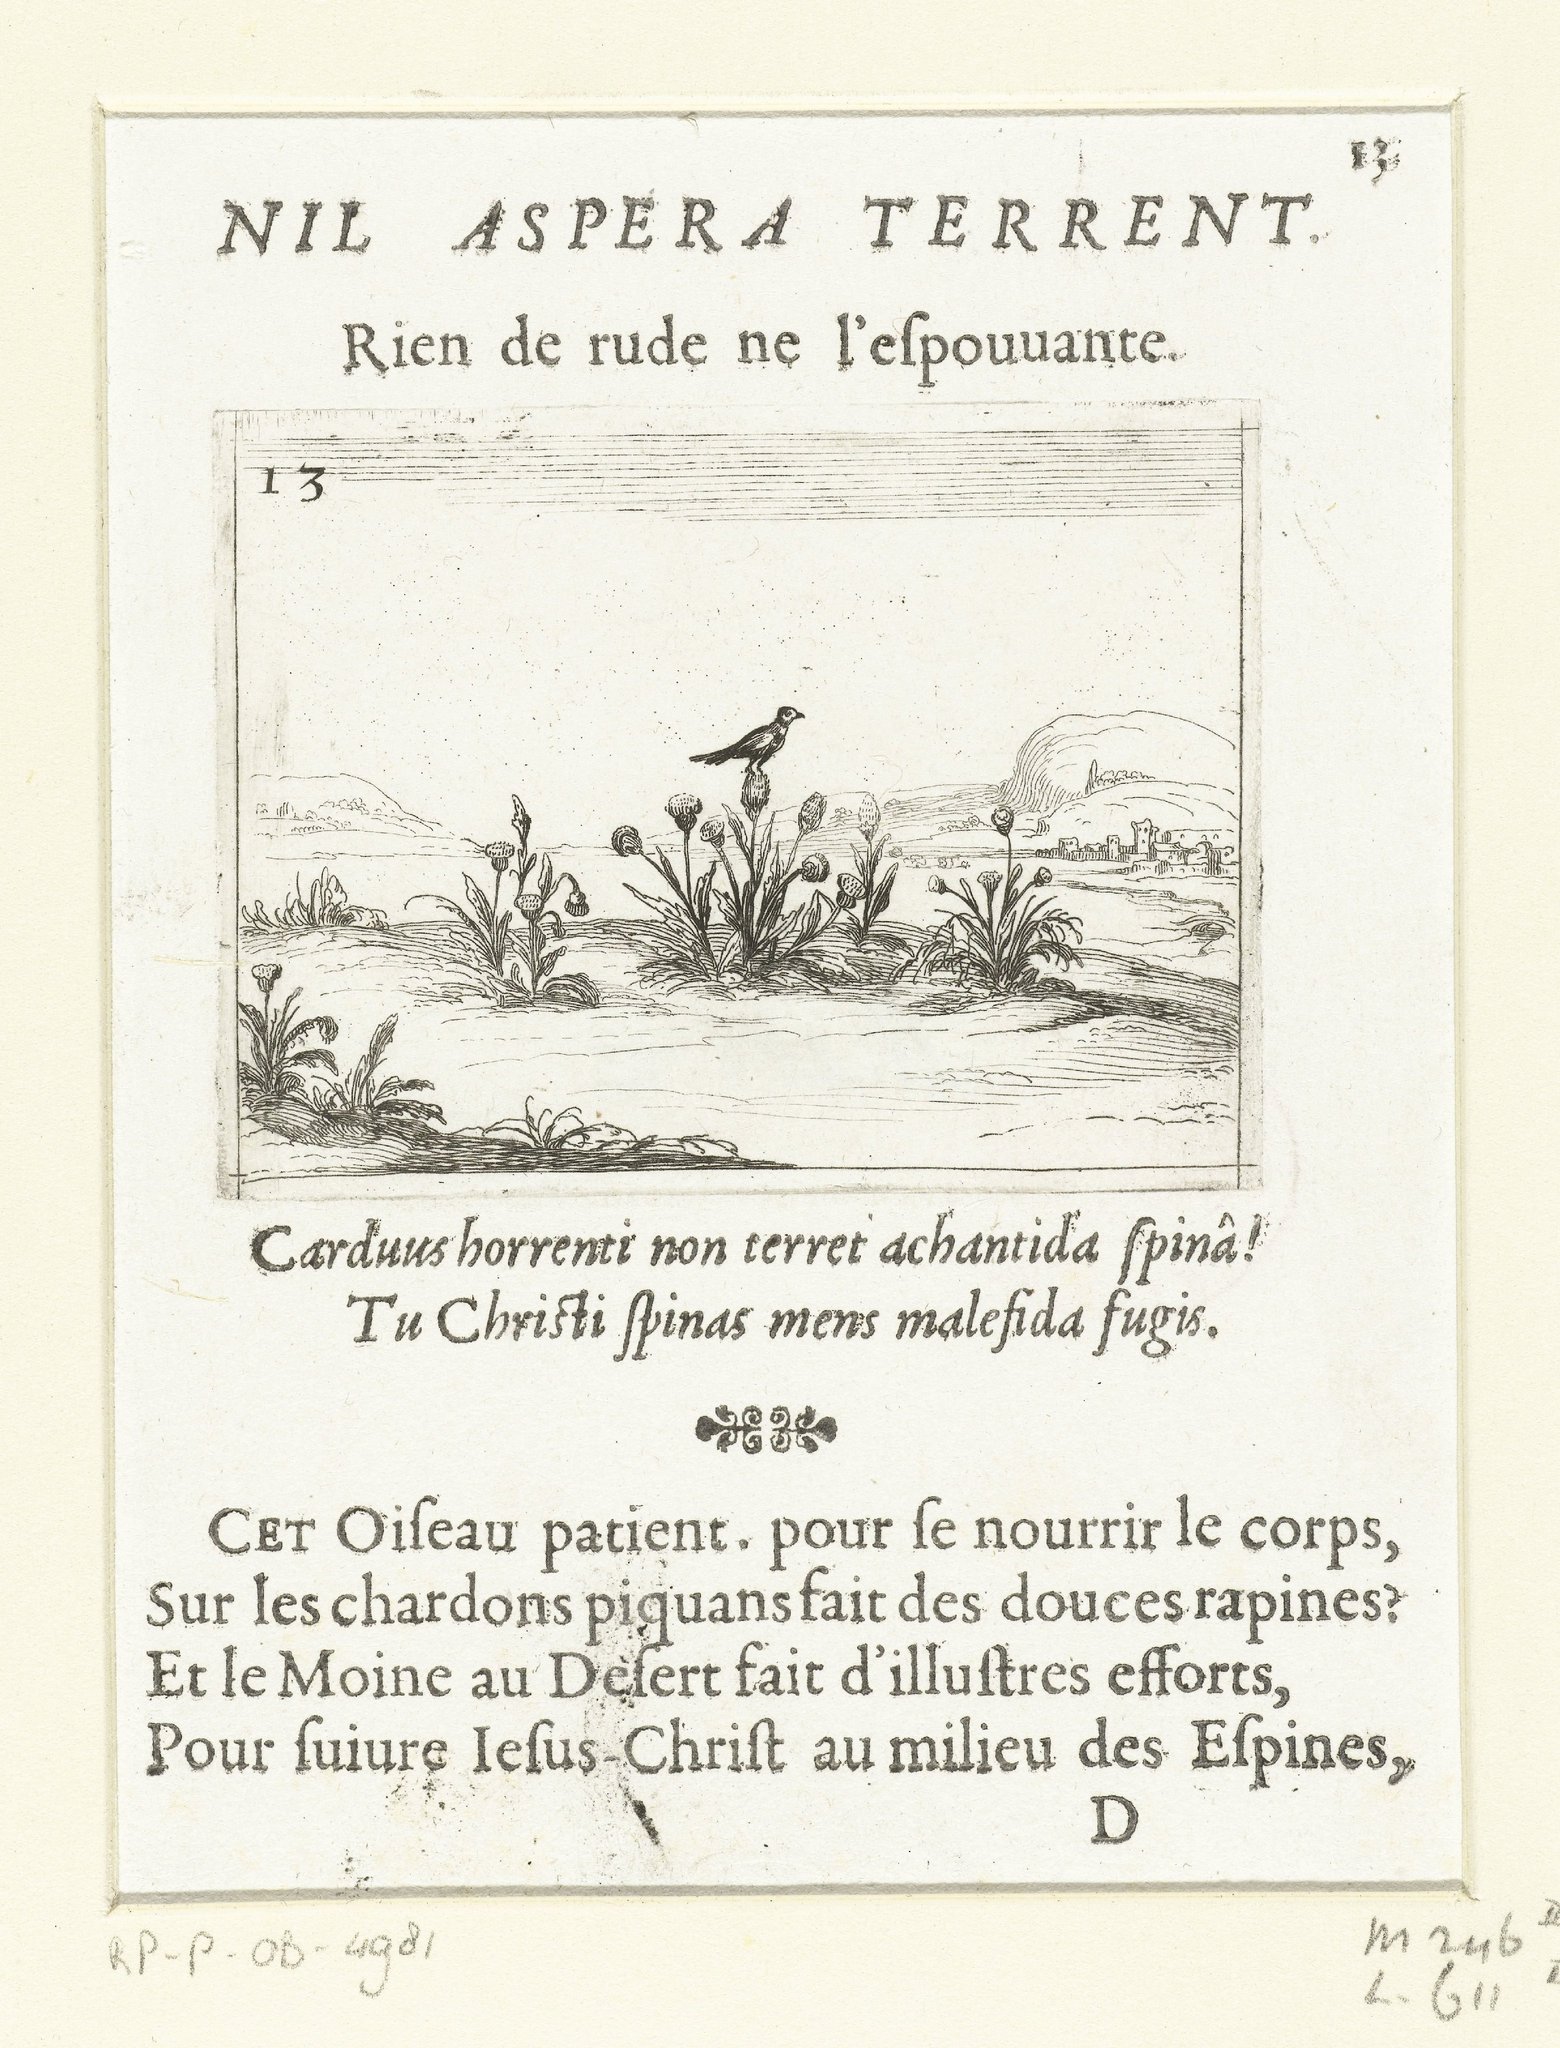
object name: print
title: Nil aspera terrent/Rien de rude ne l'espouvante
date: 1621-1635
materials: paper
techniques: etching, letterpress printing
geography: paris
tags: birds, plants and herbs: thistle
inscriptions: collector's mark: Lugt 240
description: Voorstelling van een vogel die in een verlaten landschap op een bloeiende distel zit. Boven en onder deze prent Latijnse en Franse teksten in boekdruk. Dit blad is onderdeel van de embleemserie 'Kloosterleven in emblemen'. De tweede staat van deze serie behelst naast een geïllustreerde titelpagina en 26 emblemen nog een titelpagina en een blad met opdracht, beide in boekdruk zonder afbeelding.